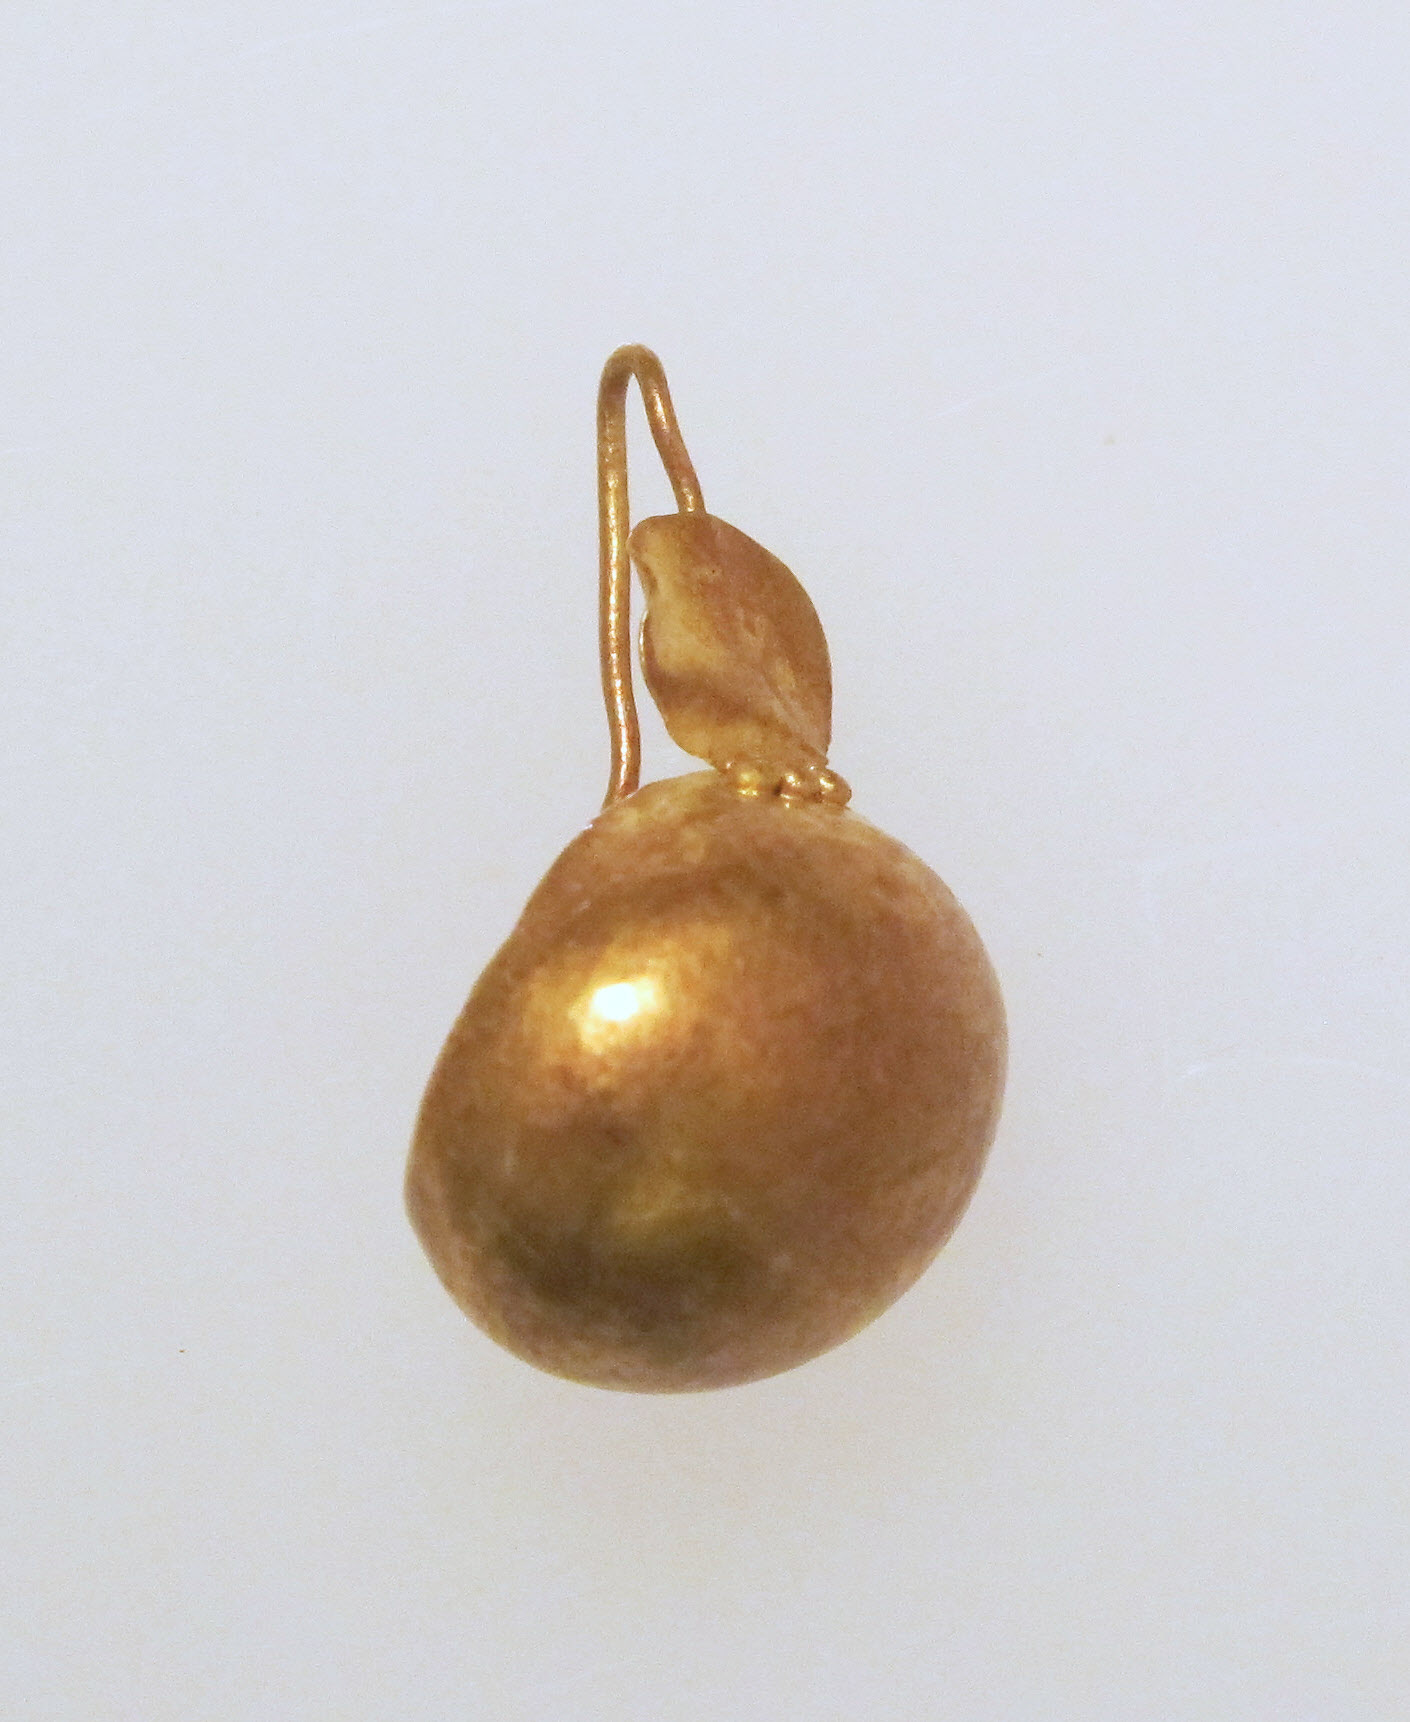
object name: earring hook type with disc of thin foil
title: Earring-hook type with discs of thin foil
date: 7000 BCE-330 CE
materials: gold